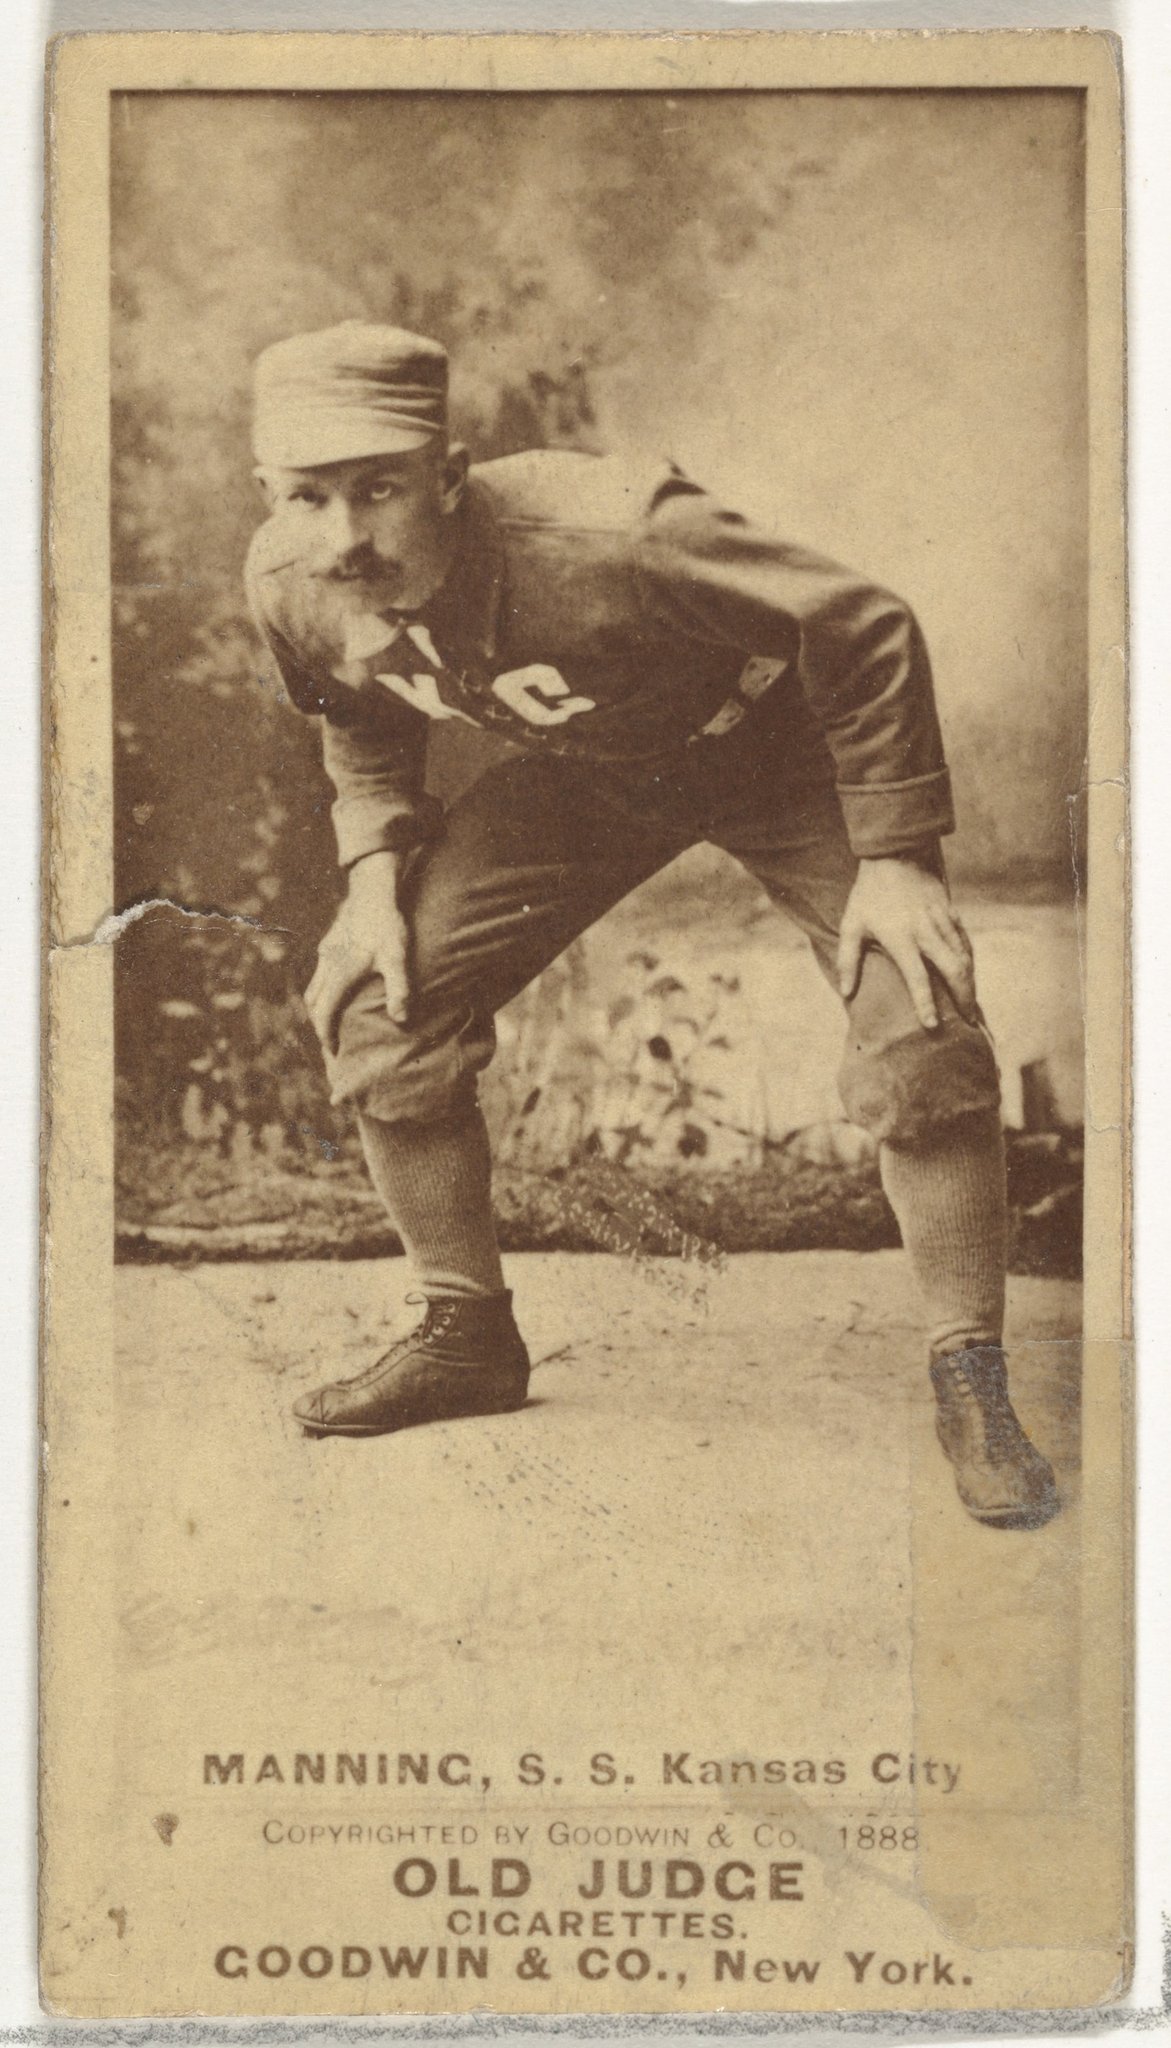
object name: baseball card, photograph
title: James H. "Jim" Manning, Shortstop, Kansas City Cowboys, from the Old Judge series (N172) for Old Judge Cigarettes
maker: goodwin & company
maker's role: publisher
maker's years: 1850-1950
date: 1888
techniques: albumen silver print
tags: men,portraits,baseball,athletes